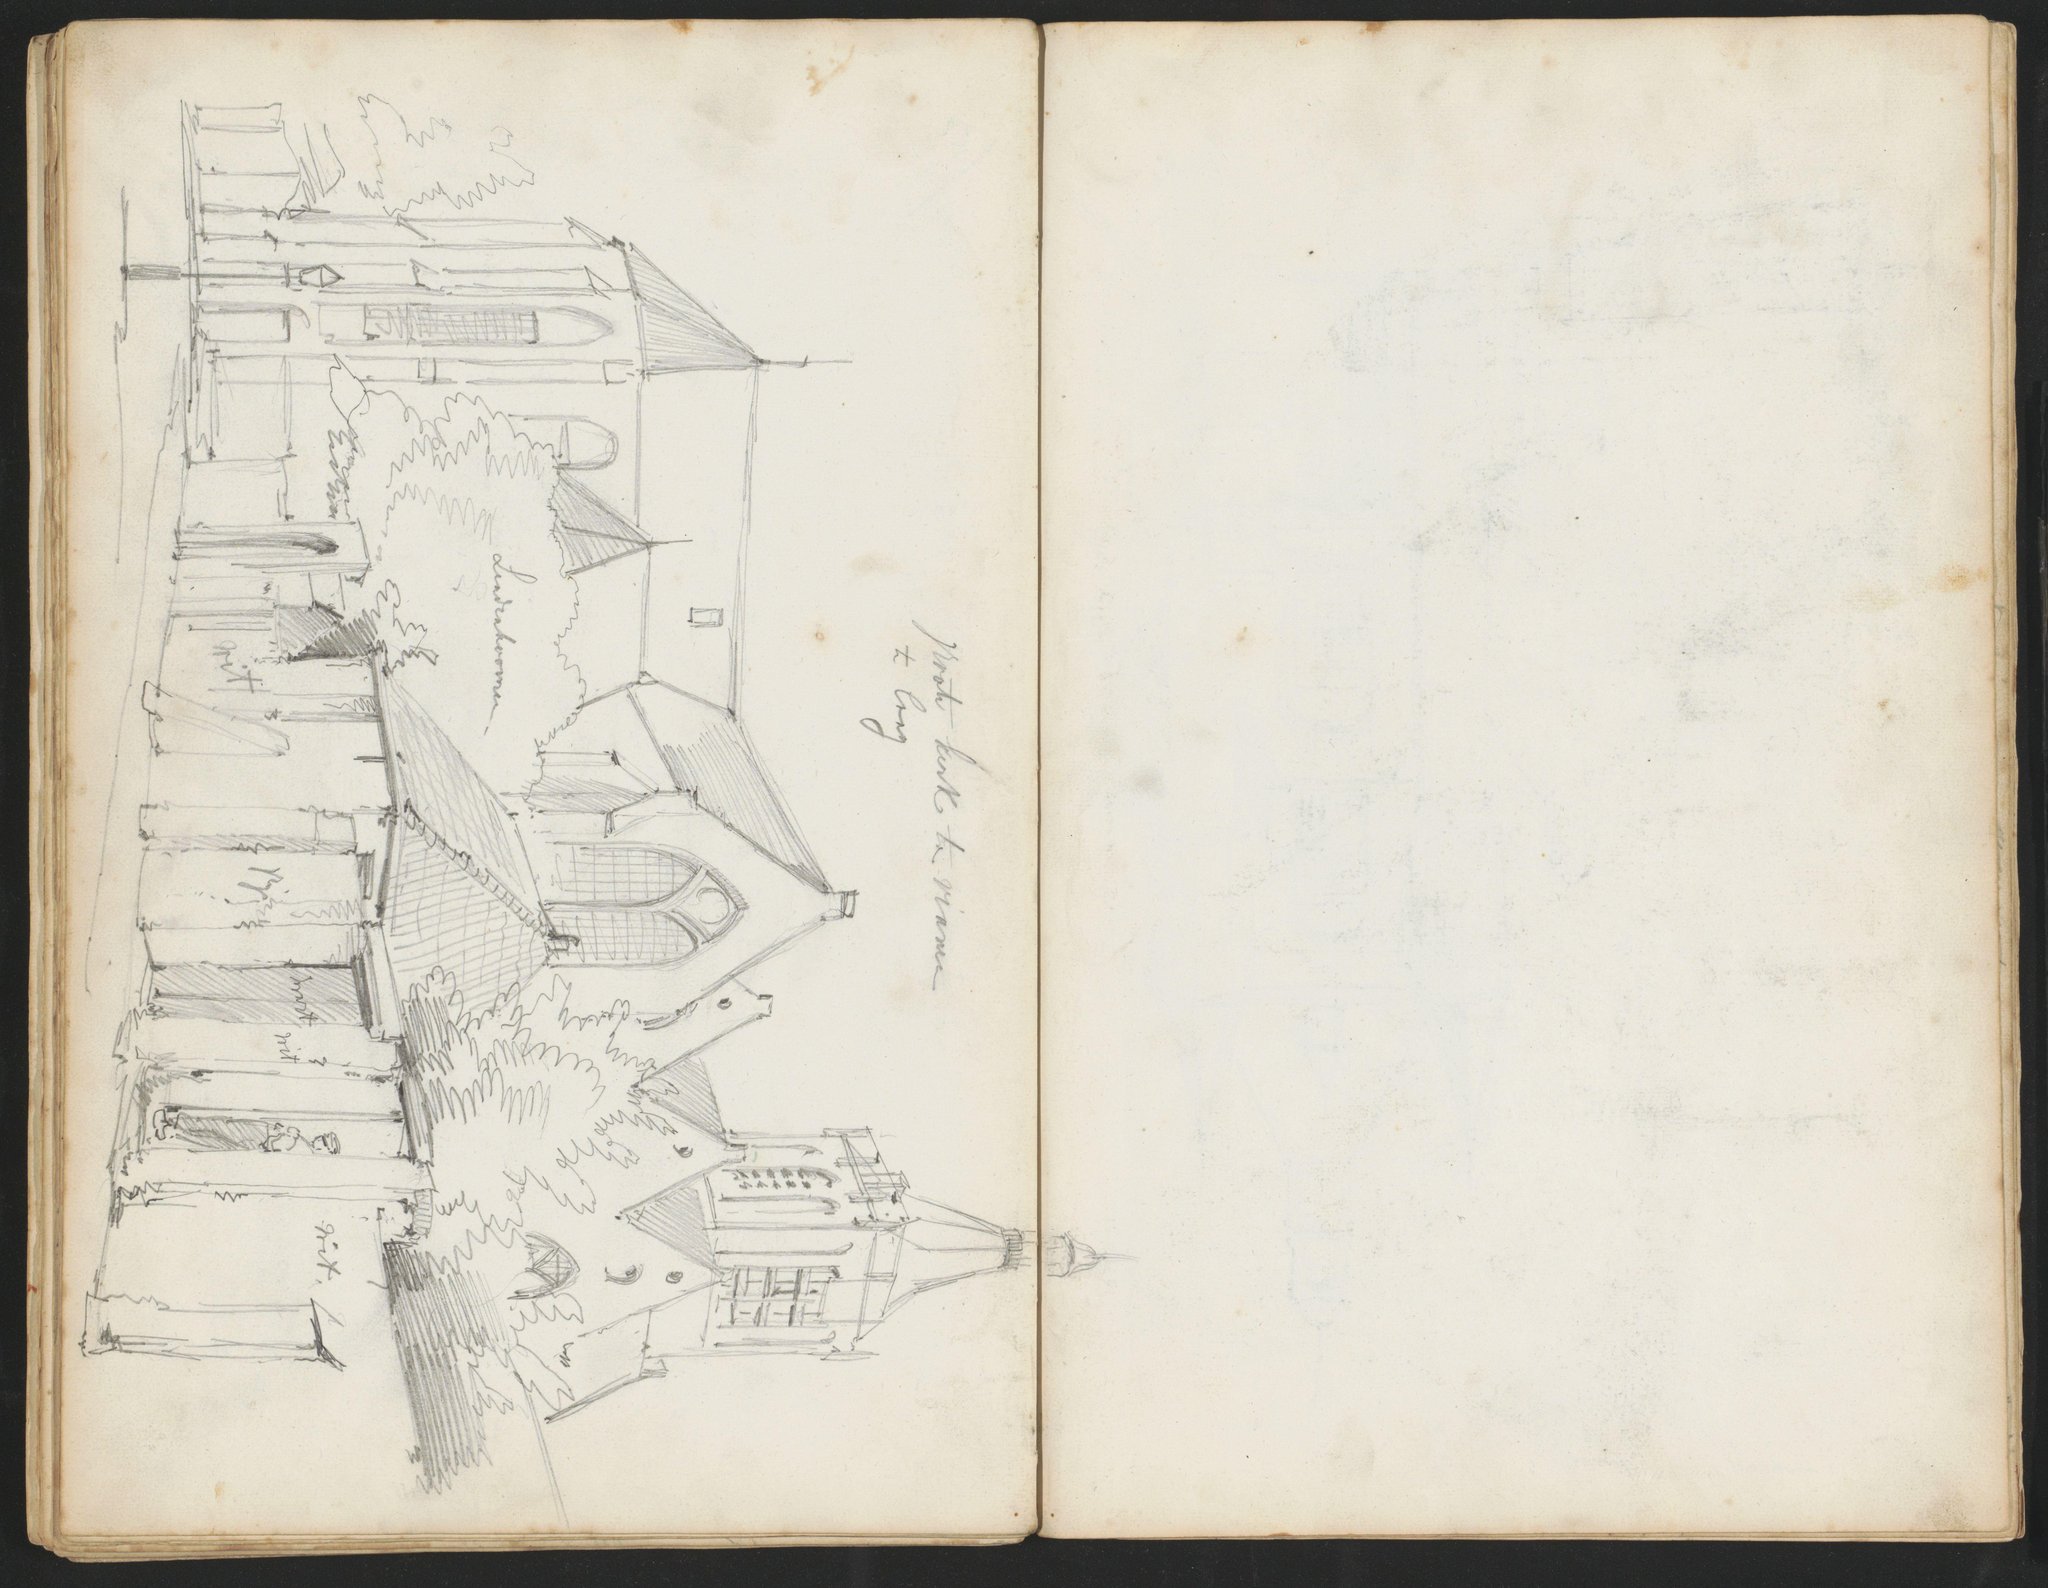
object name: sketchbook leaf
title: Grote Kerk te Vianen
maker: willem koekkoek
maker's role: draughtsman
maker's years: 1839-1895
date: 1849-1895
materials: paper, pencil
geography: vianen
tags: church (exterior)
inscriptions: annotation: ‘grote kerk te vianen/ te laag/ Lindenboomen’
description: Blad 32 verso uit een schetsboek met 42 bladen.